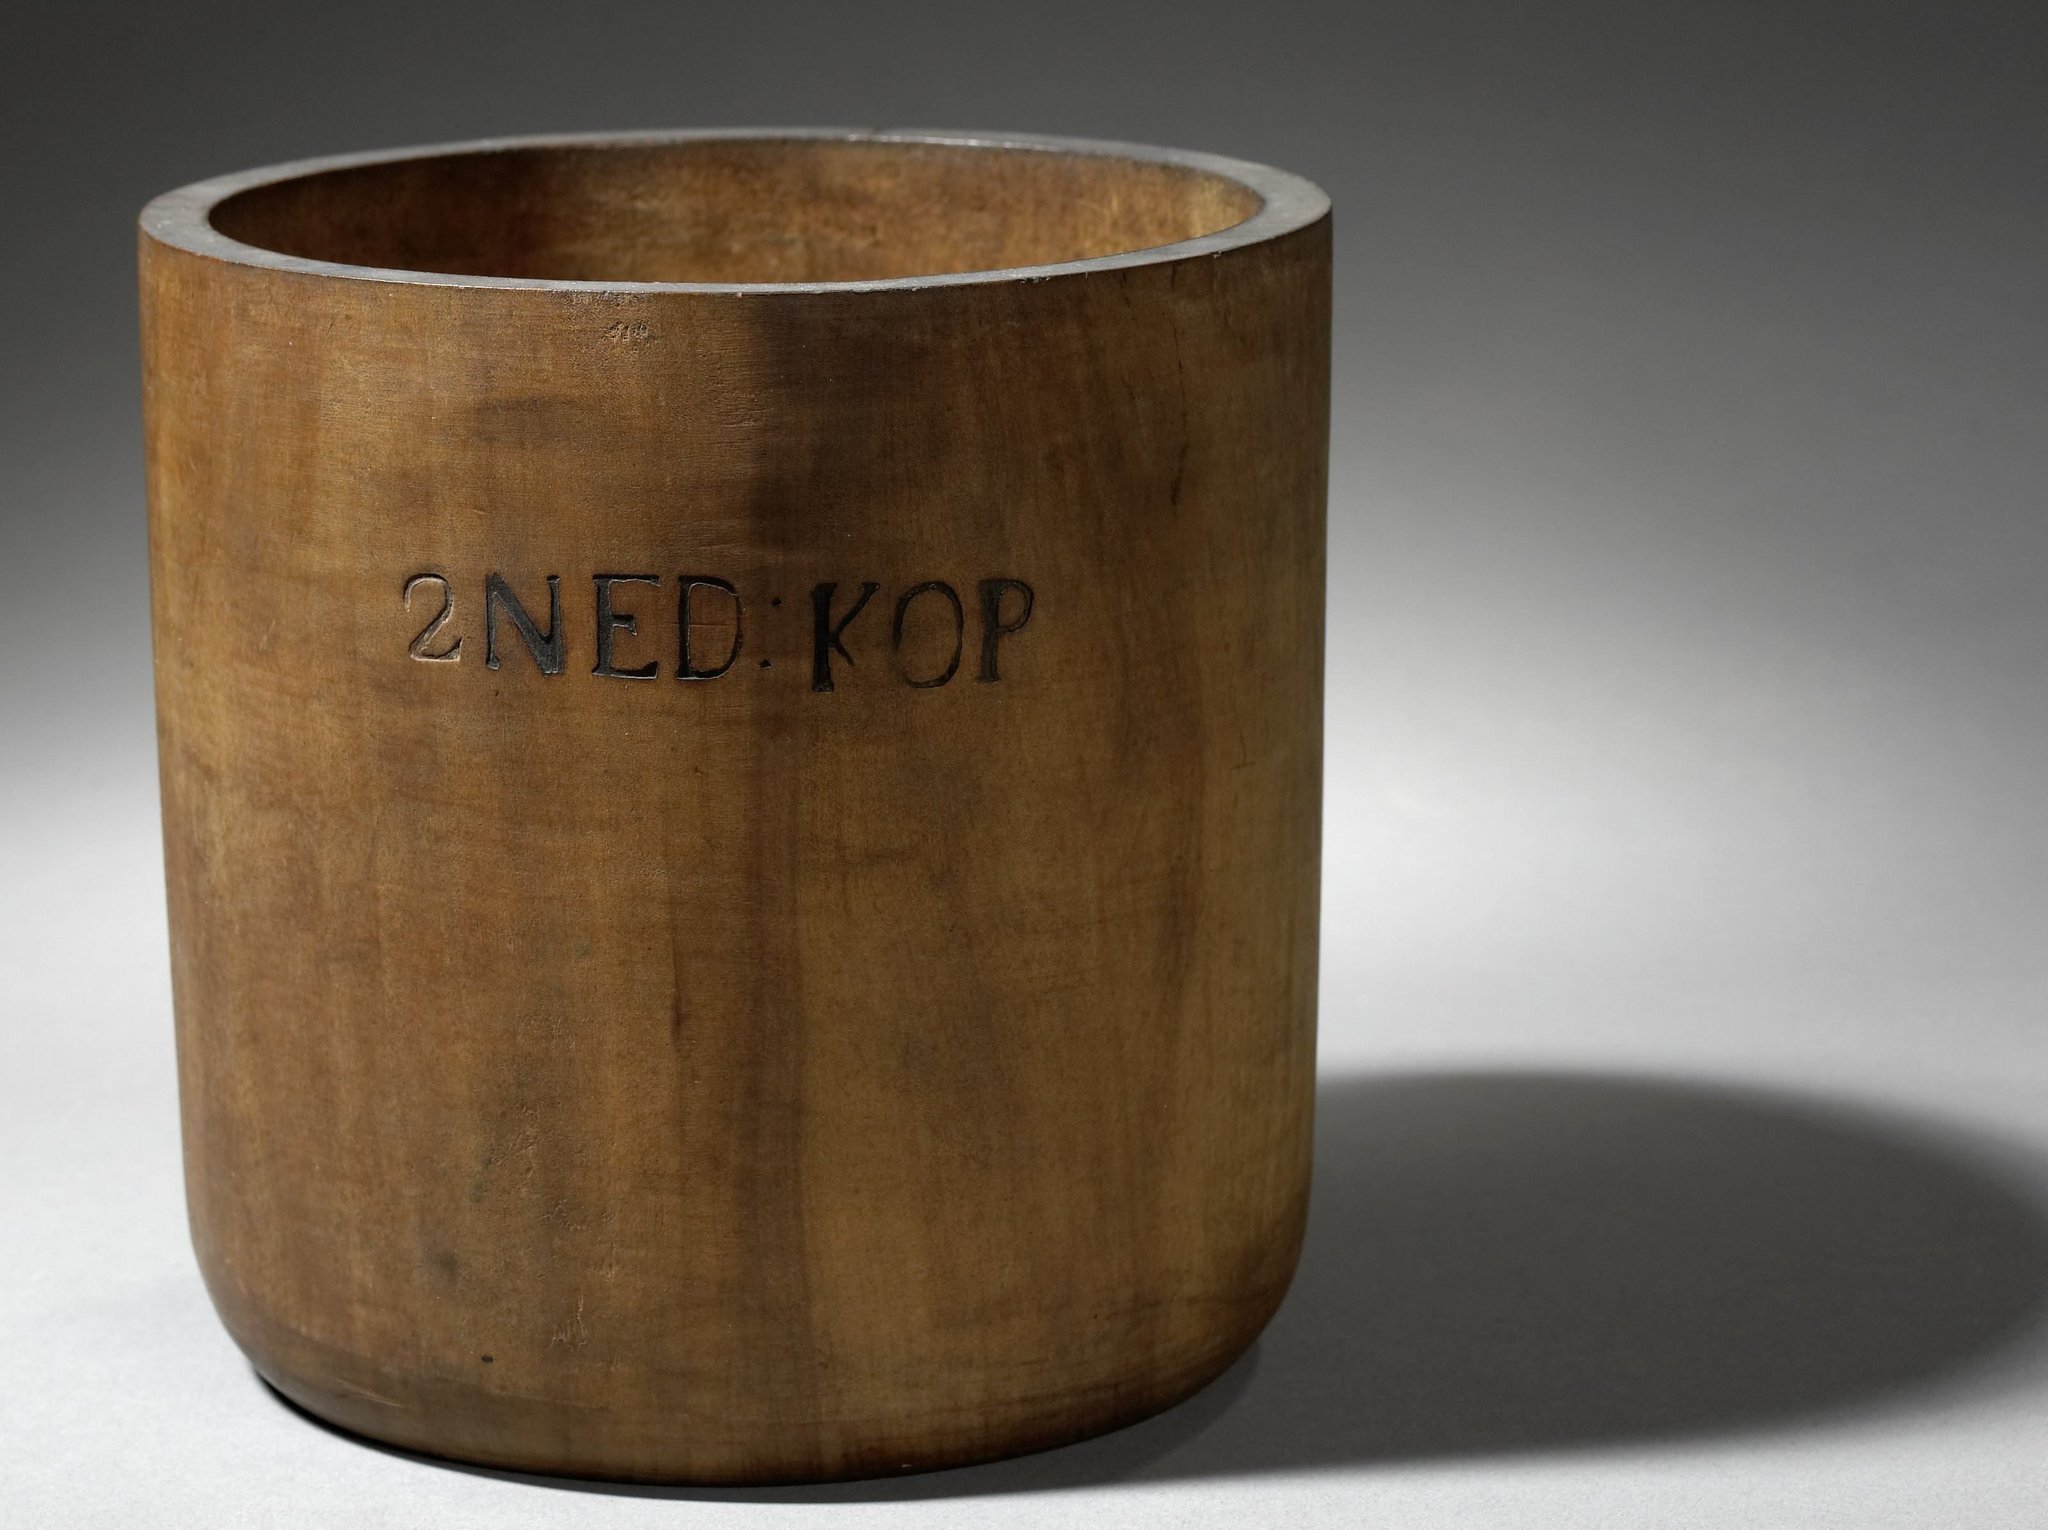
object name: inhoudsmaat droge waren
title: Inhoudsmaat van 2 NED KOP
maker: Anonymous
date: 1825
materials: wood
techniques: turning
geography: netherlands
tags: netherlands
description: Gedraaid houten inhoudsmaat van 2 liter.